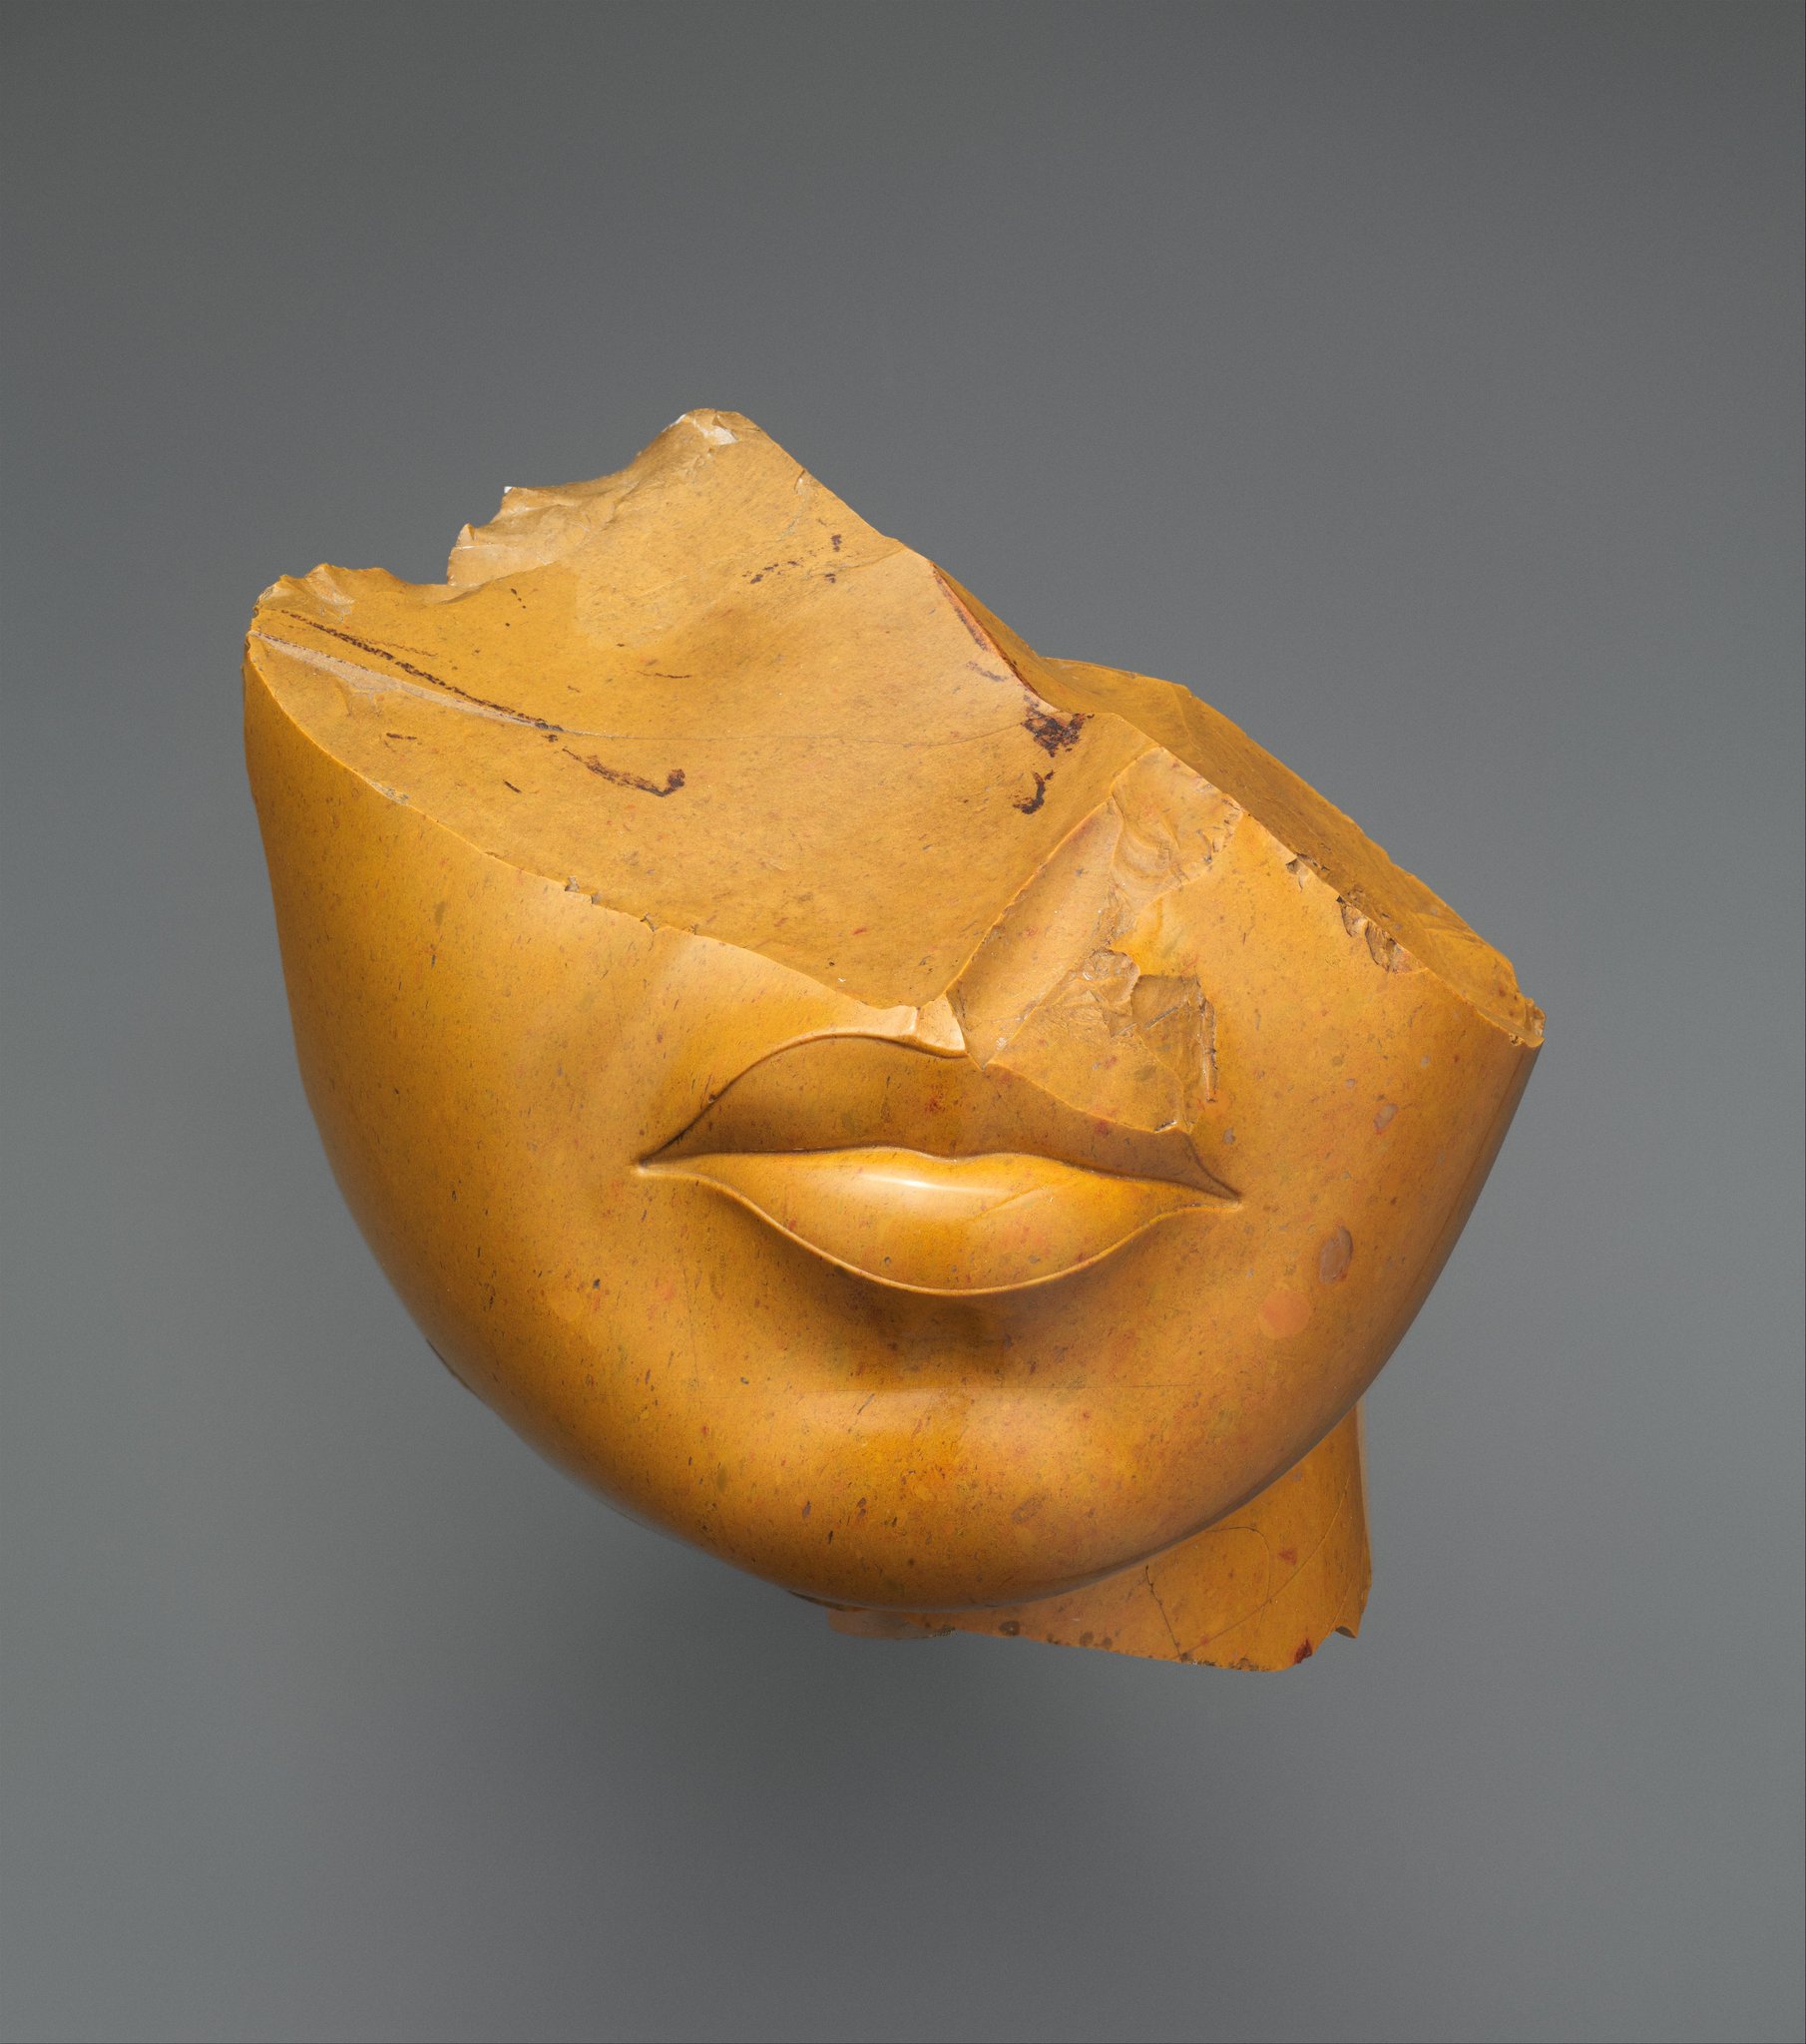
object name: head, queen, fragment, lip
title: Fragment of a Queen's Face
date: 1390-1336 BCE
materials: jasper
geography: middle egypt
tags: queens,faces,women